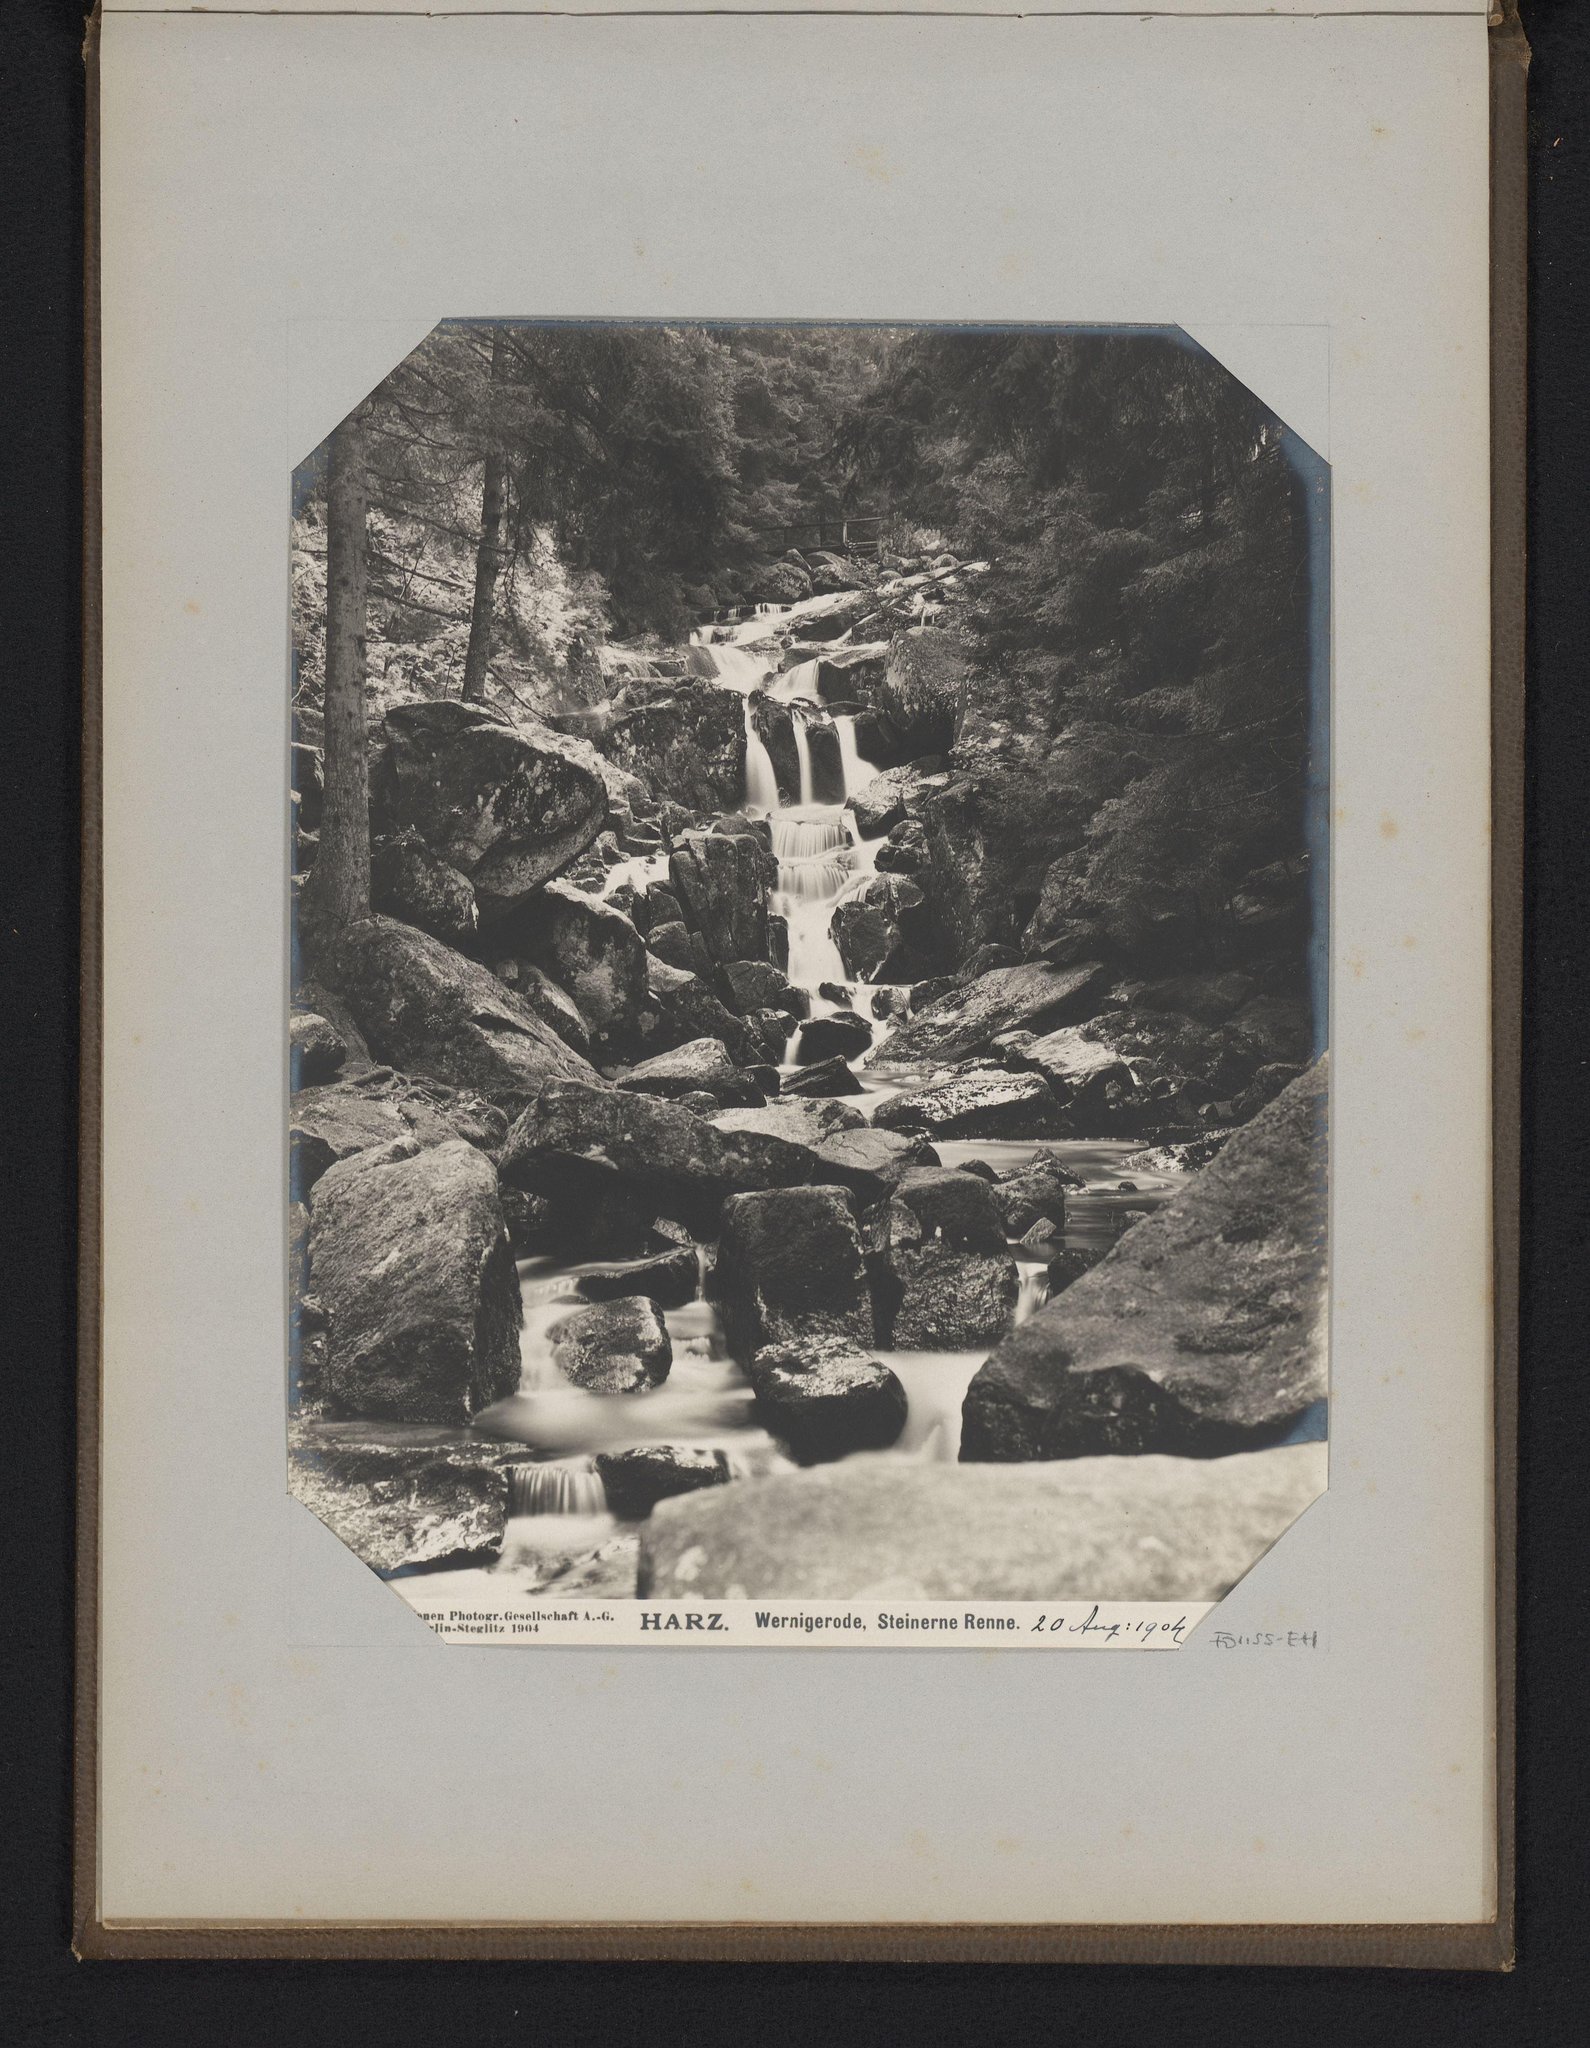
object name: album leaf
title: Gezicht op de Steinerne Renne nabij Wernigerode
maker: Anonymous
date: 1904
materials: photographic support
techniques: gelatin silver print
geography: harz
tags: waterfall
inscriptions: date: ‘20 Aug: 1904’, inscription: ‘Verlag der Neuen Photogr. Gesellschaft A.-G./ Berlin-Steglitz 1904/ Harz. Wernigerode, Steinerne Renne/ 1639’